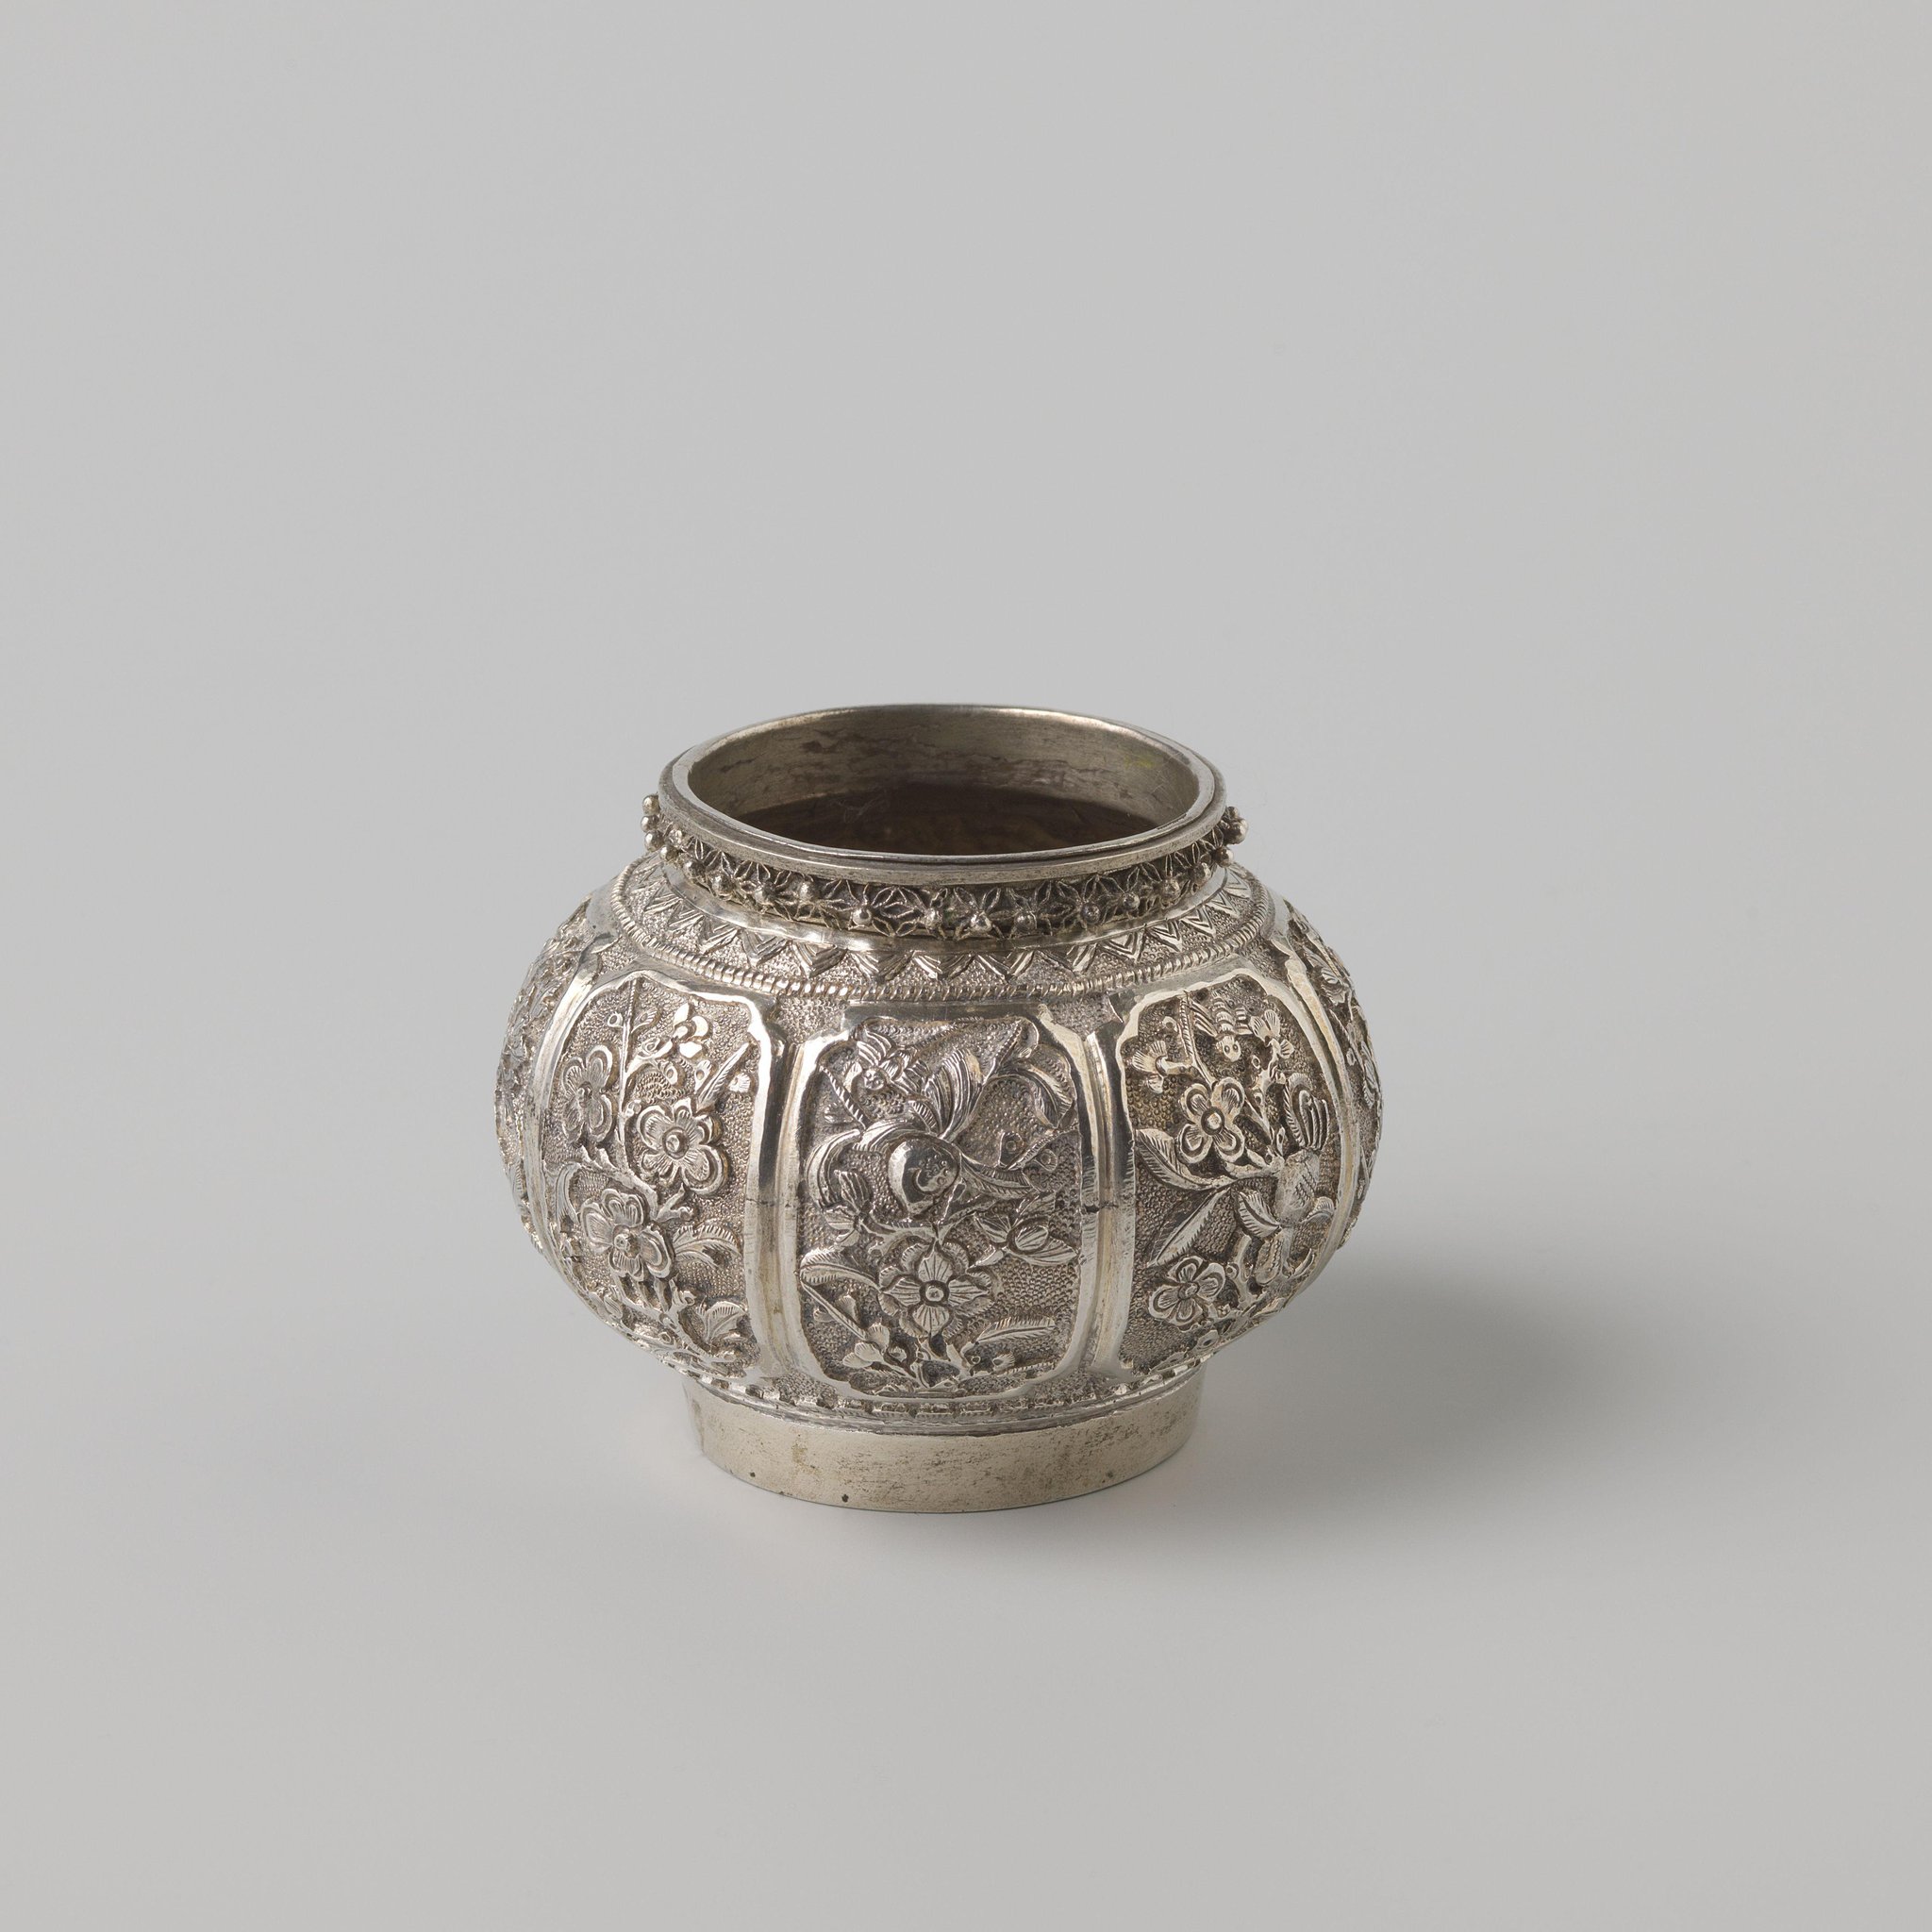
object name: pot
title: Zilveren potje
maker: Anonymous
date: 1700-1799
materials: silver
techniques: forging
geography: malaysia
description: Bolle potje op verhoogd plat voetje en met opstaande rand rond de opening. Geheel versierd met drijfwerk: acht taferelen met iedere keer verschillende bloemstukken. Opschrift ingekrast.